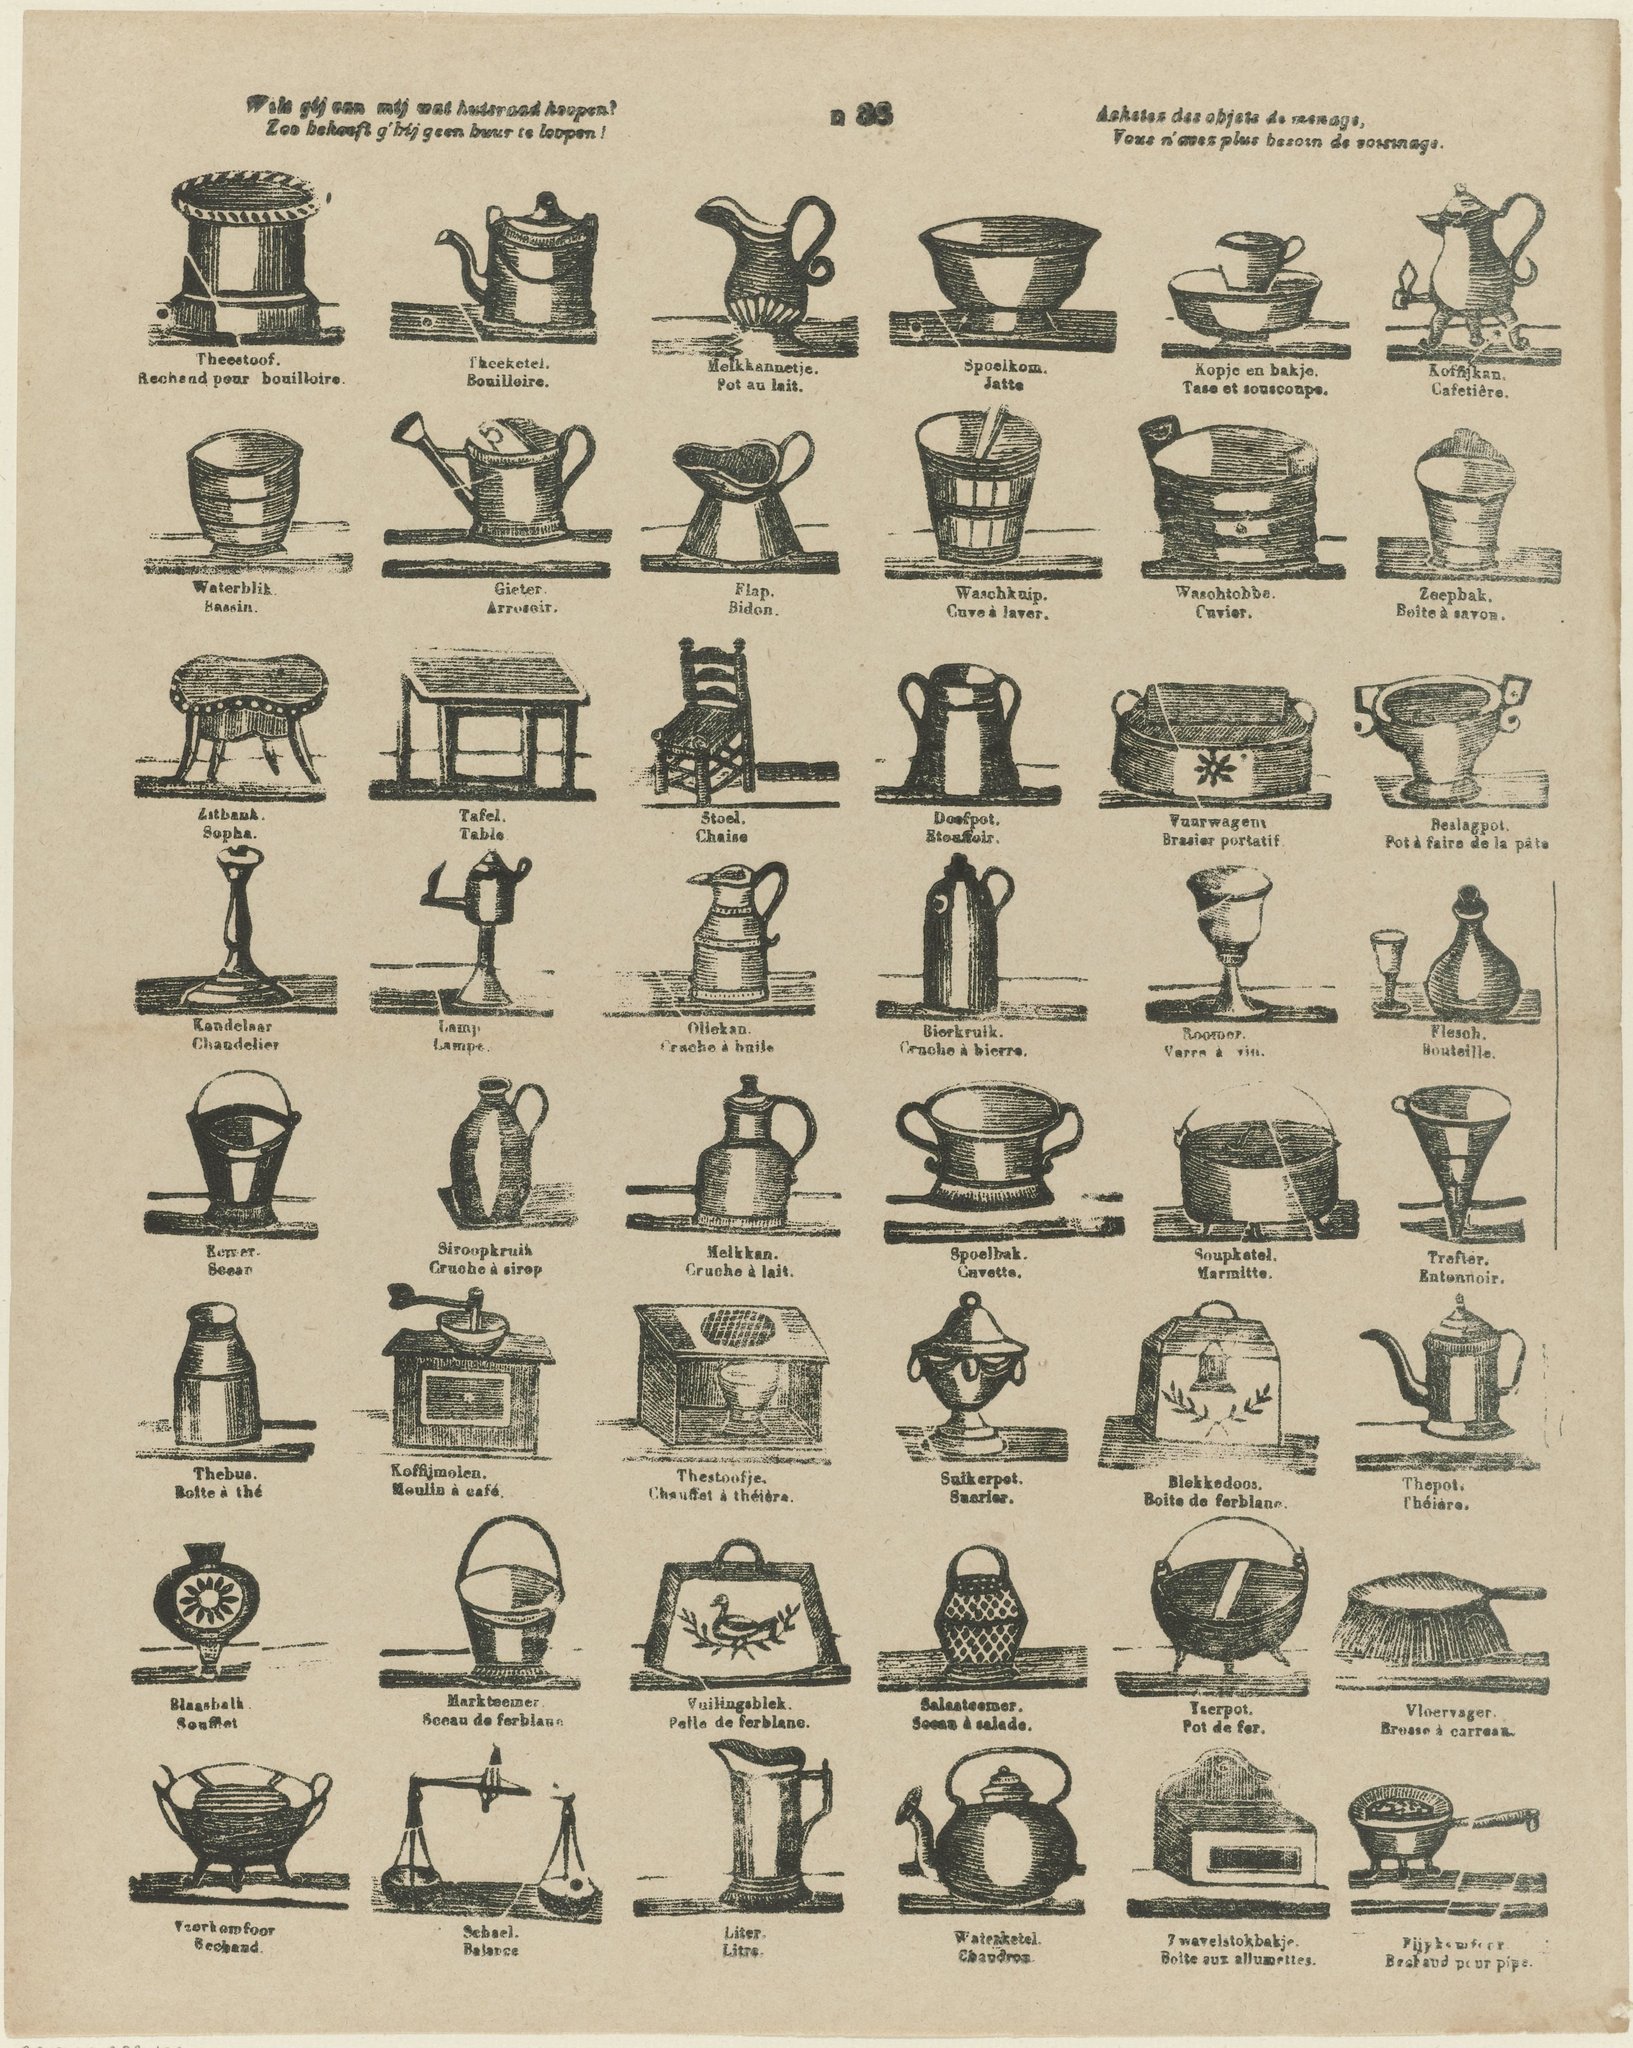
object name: popular print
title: Wilt gij van mij wat huisraad koopen? / Zoo behoeft g'bij geen buur te loopen! / Achetez des objets de menage, / Vous n'avez plus beson de voisinage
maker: Anonymous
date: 1856-1900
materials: paper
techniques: letterpress printing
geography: turnhout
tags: (household) utensils and implements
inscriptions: collector's mark: Lugt 2760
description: Blad met 48 voorstellingen van alledaagse voorwerpen (huisraad), waaronder een theepot, een gieter, een bierkruik, een koffiemolen, een blaasbalg en een weegschaal. Onder elke afbeelding een onderschrift in het Nederlands en in het Frans. Genummerd midden boven: n 38.